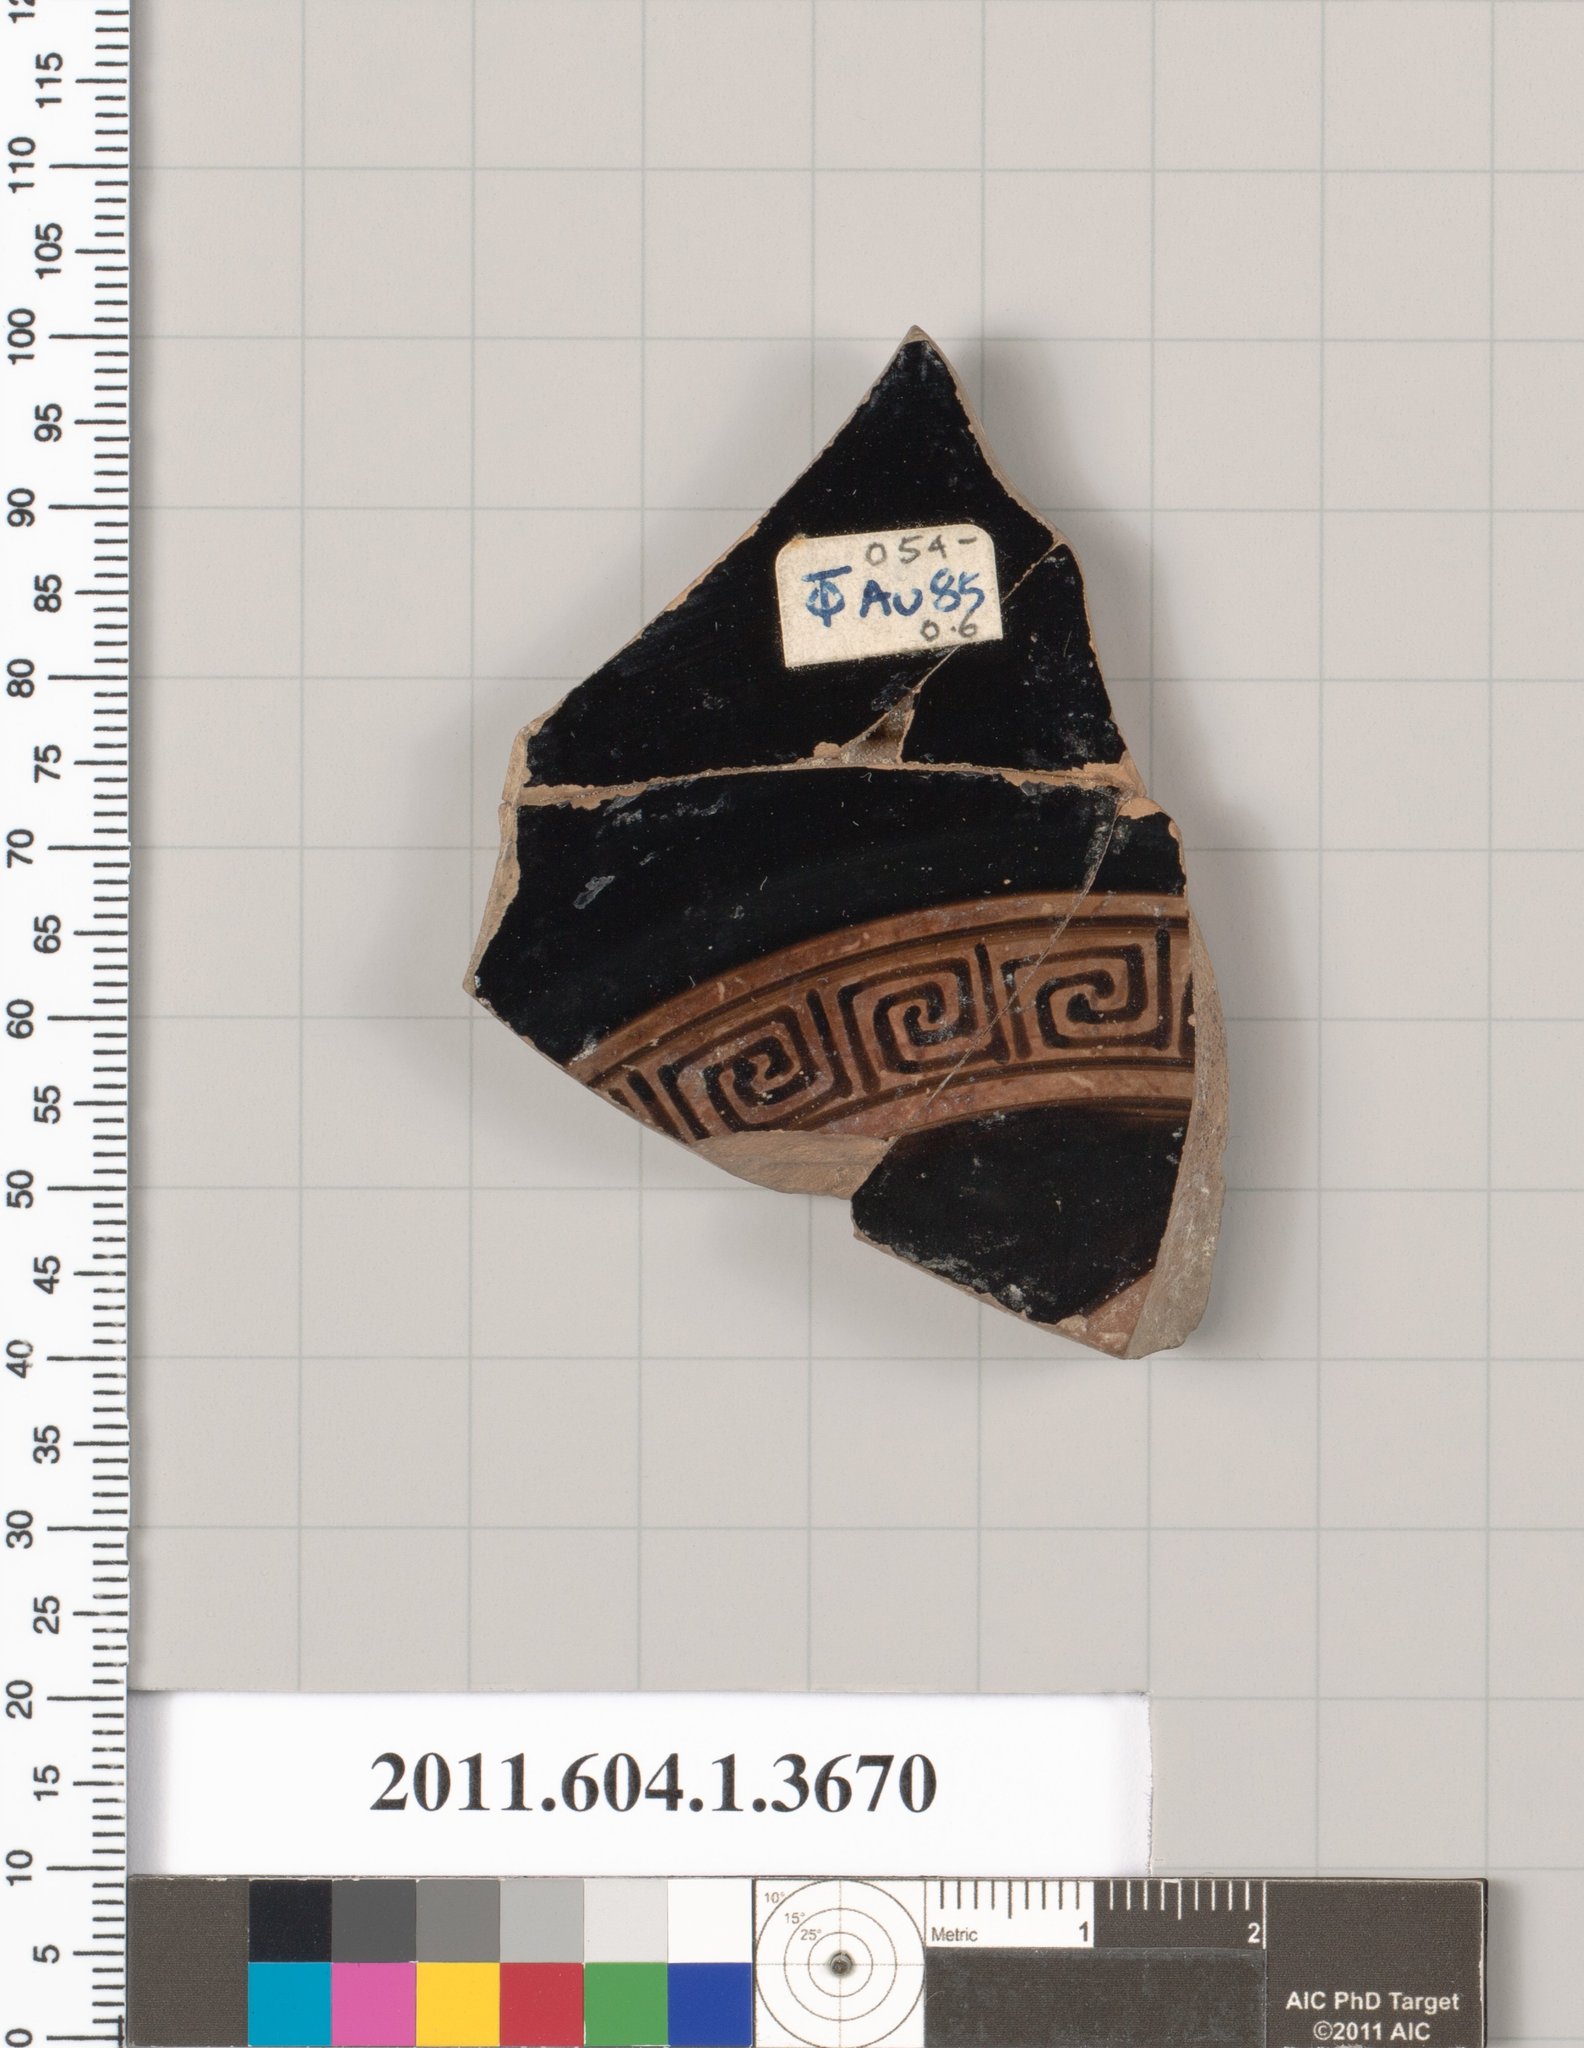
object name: kylix fragment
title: Terracotta fragment of a kylix (drinking cup)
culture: greek, attic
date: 510-470 BCE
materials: terracotta